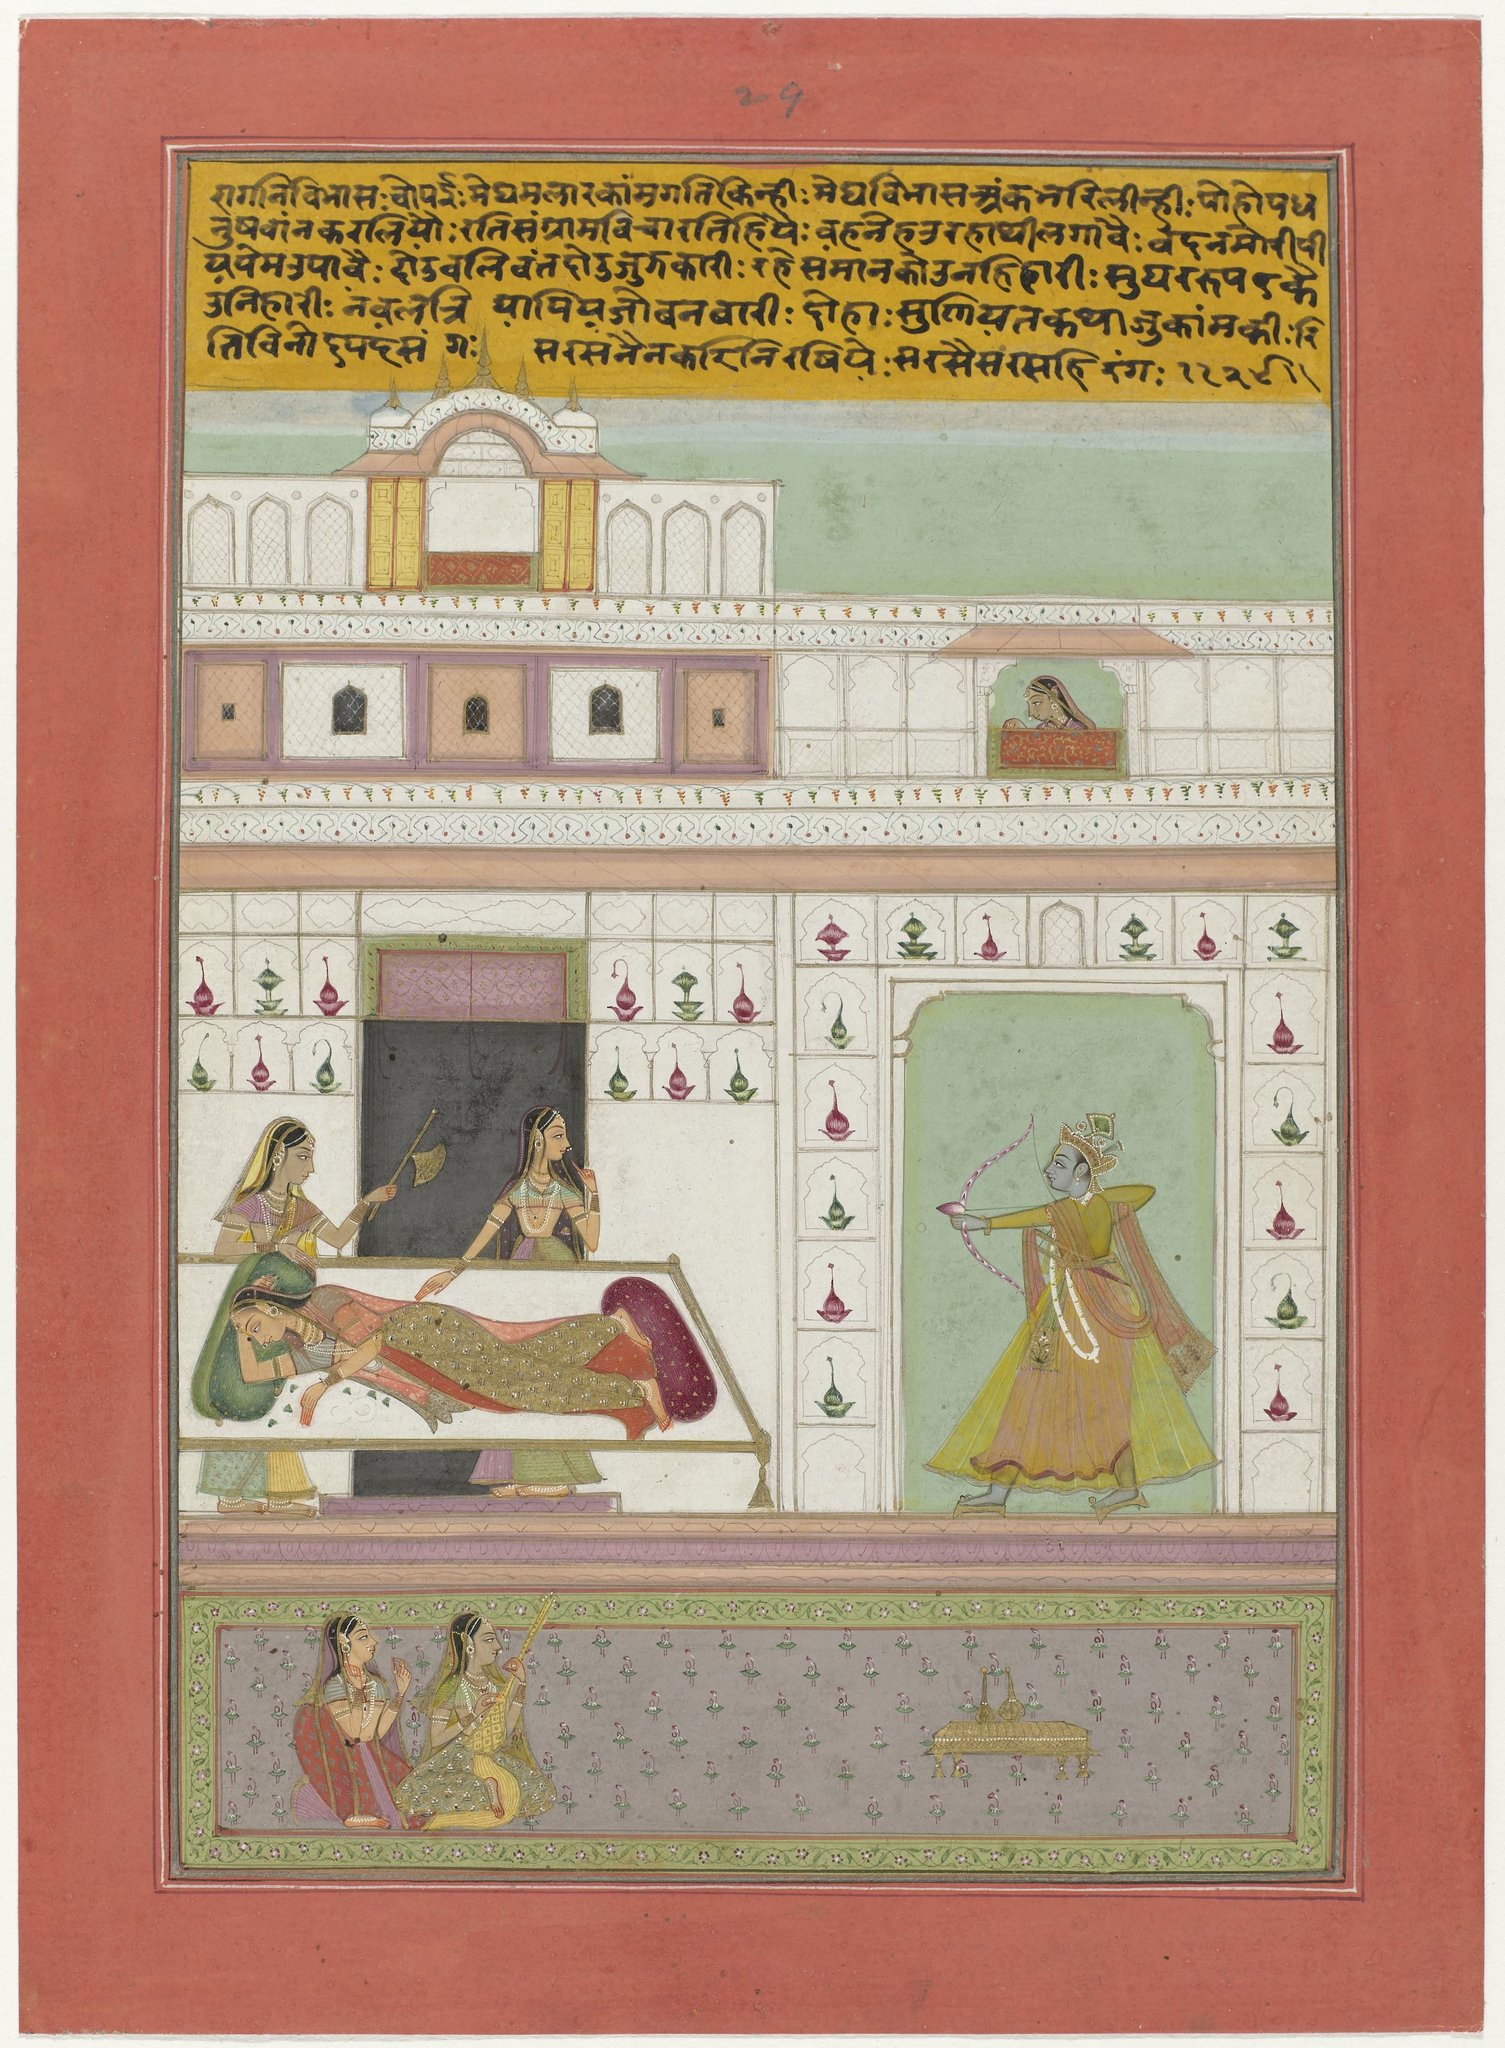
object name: indian miniature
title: Vibhara ragini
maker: Anonymous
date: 1760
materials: paper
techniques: brush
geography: central india